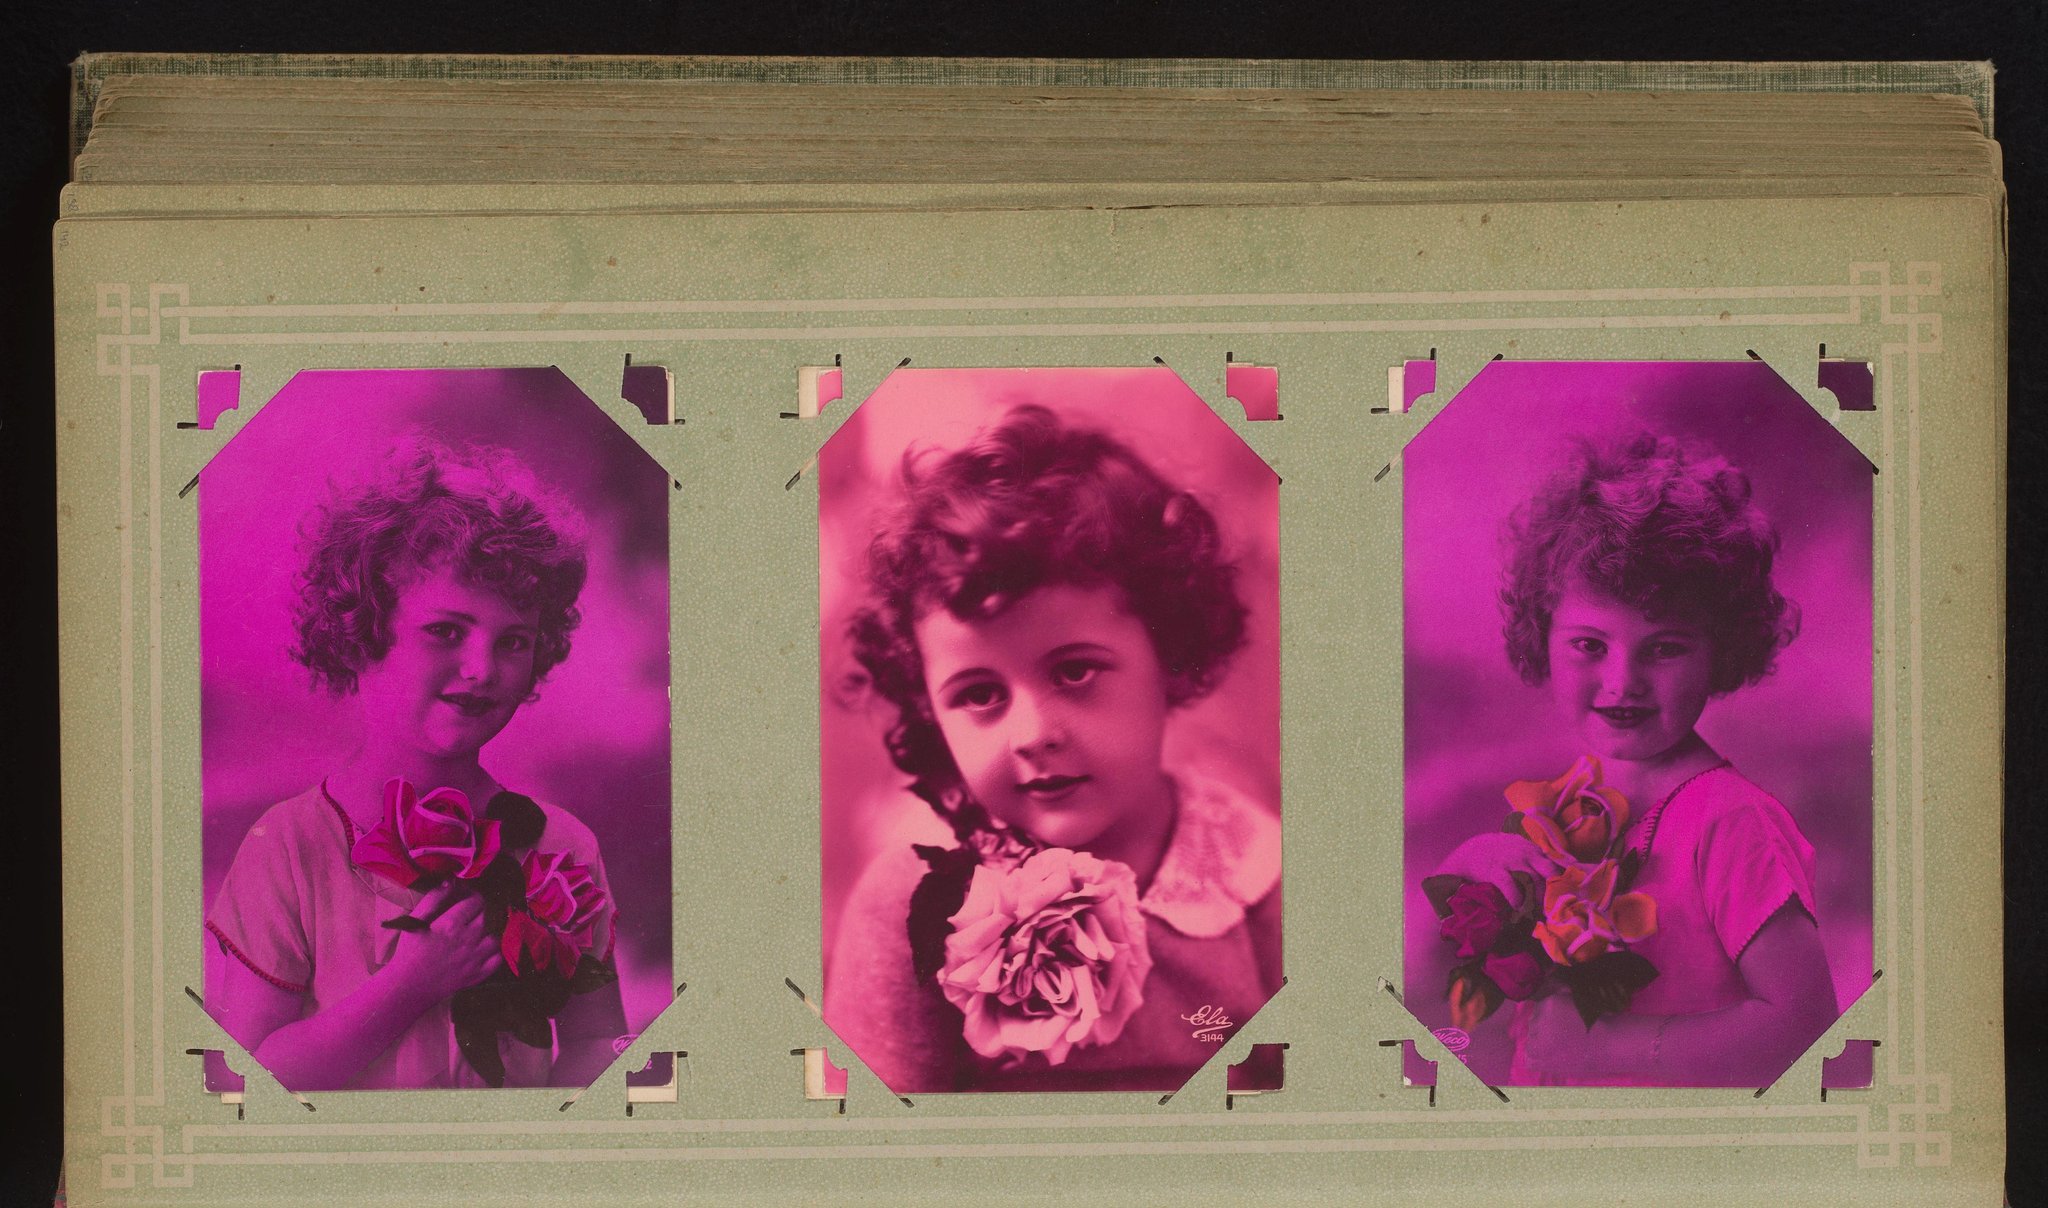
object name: photograph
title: Drie portretten van een meisje met bloemen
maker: Anonymous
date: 1900-1930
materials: cardboard, photographic support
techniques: gelatin silver print, hand coloring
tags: flowers, historical persons - bb - woman, girl (child between toddler and youth)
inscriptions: monogram: ‘Ela’, monogram: ‘Weco’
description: Deze foto's maken deel uit van een album.